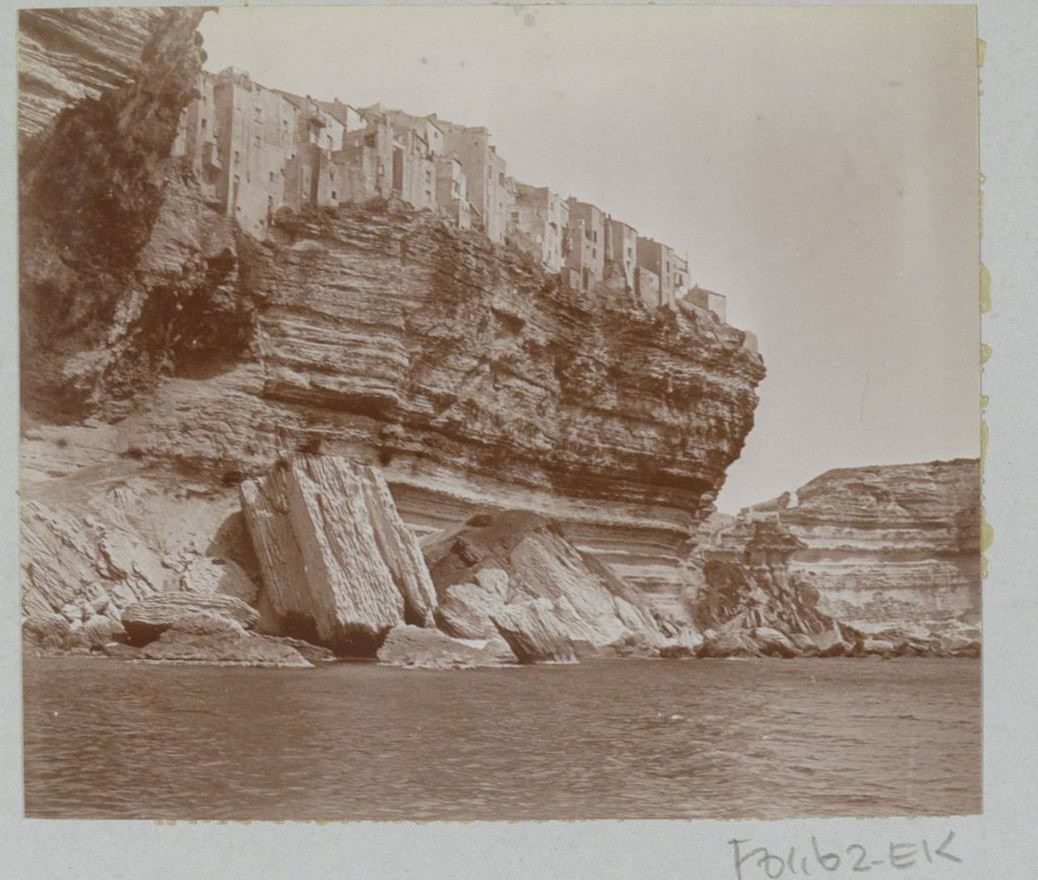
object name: photograph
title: Gezicht op de kliffen bij Bonifacio op Corsica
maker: Anonymous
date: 1905-1910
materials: paper, photographic support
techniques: gelatin silver print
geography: corsica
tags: coastal cliff or crag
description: Onderdeel van Fotoalbum van een Franse amateurfotograaf met bezienswaardigheden in Frankrijk, Zwitserland en Italië.